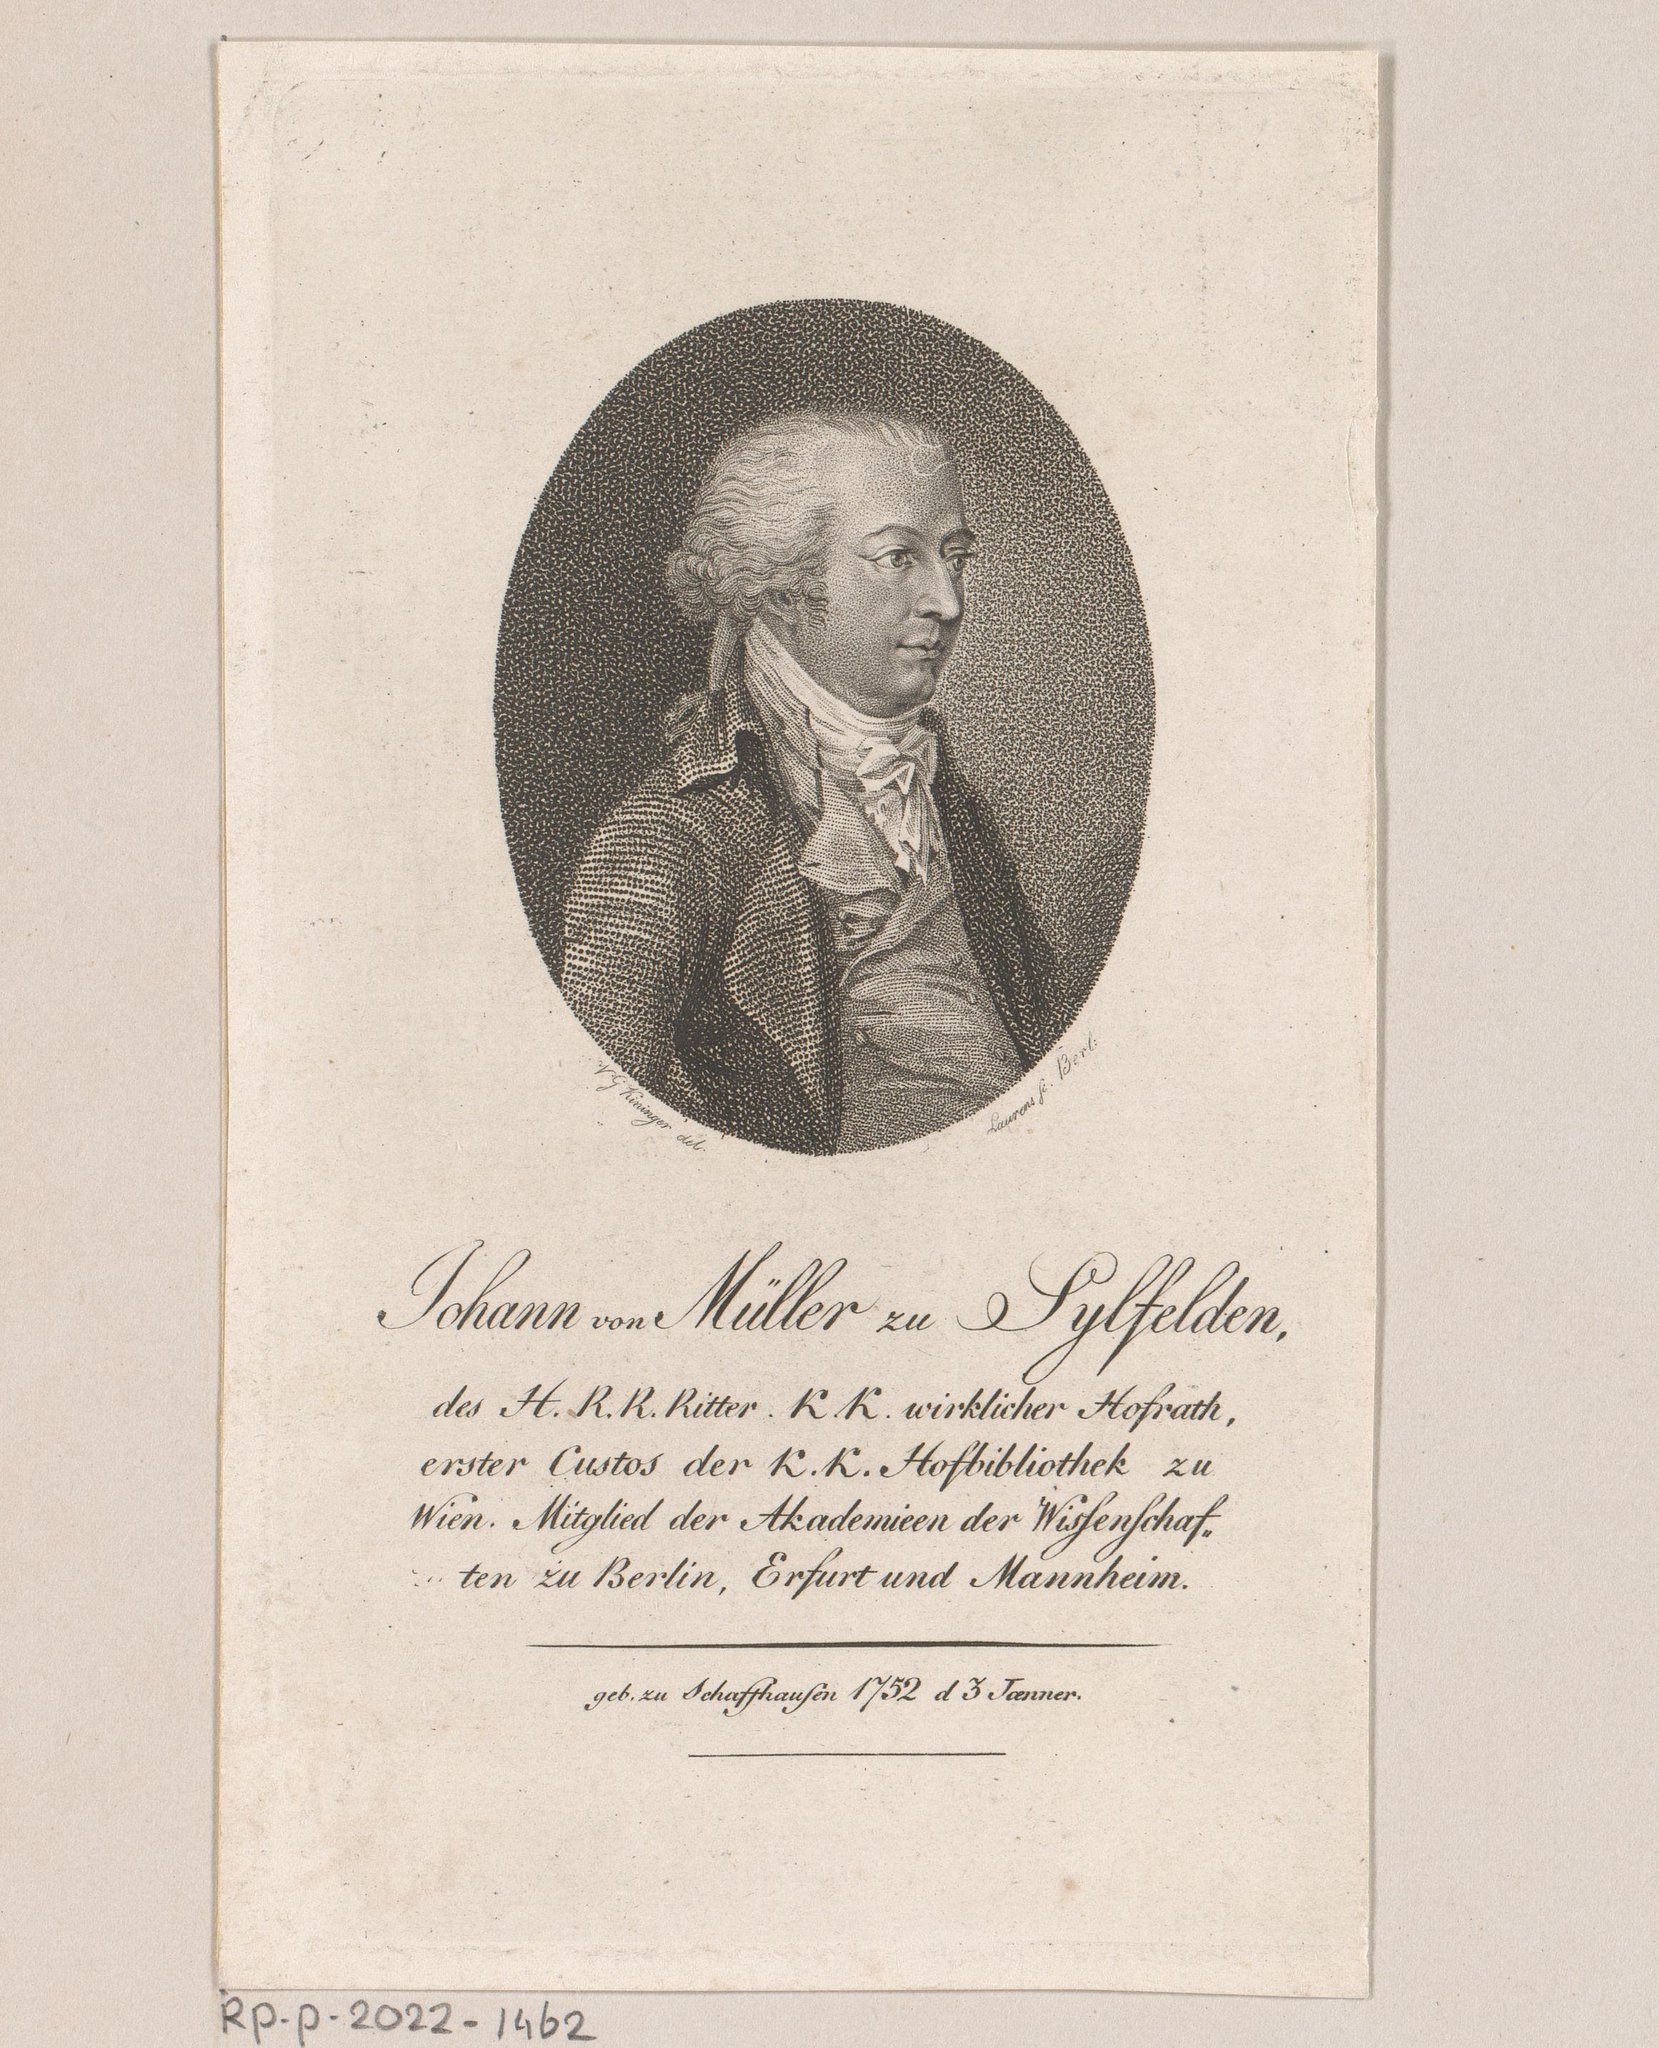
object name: print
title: Portret van Johannes von Müller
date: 1791-1832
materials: paper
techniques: engraving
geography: vienna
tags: further education (+ portrait of teacher, professor), historical persons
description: Met vierregelig onderschrift in het Duits.